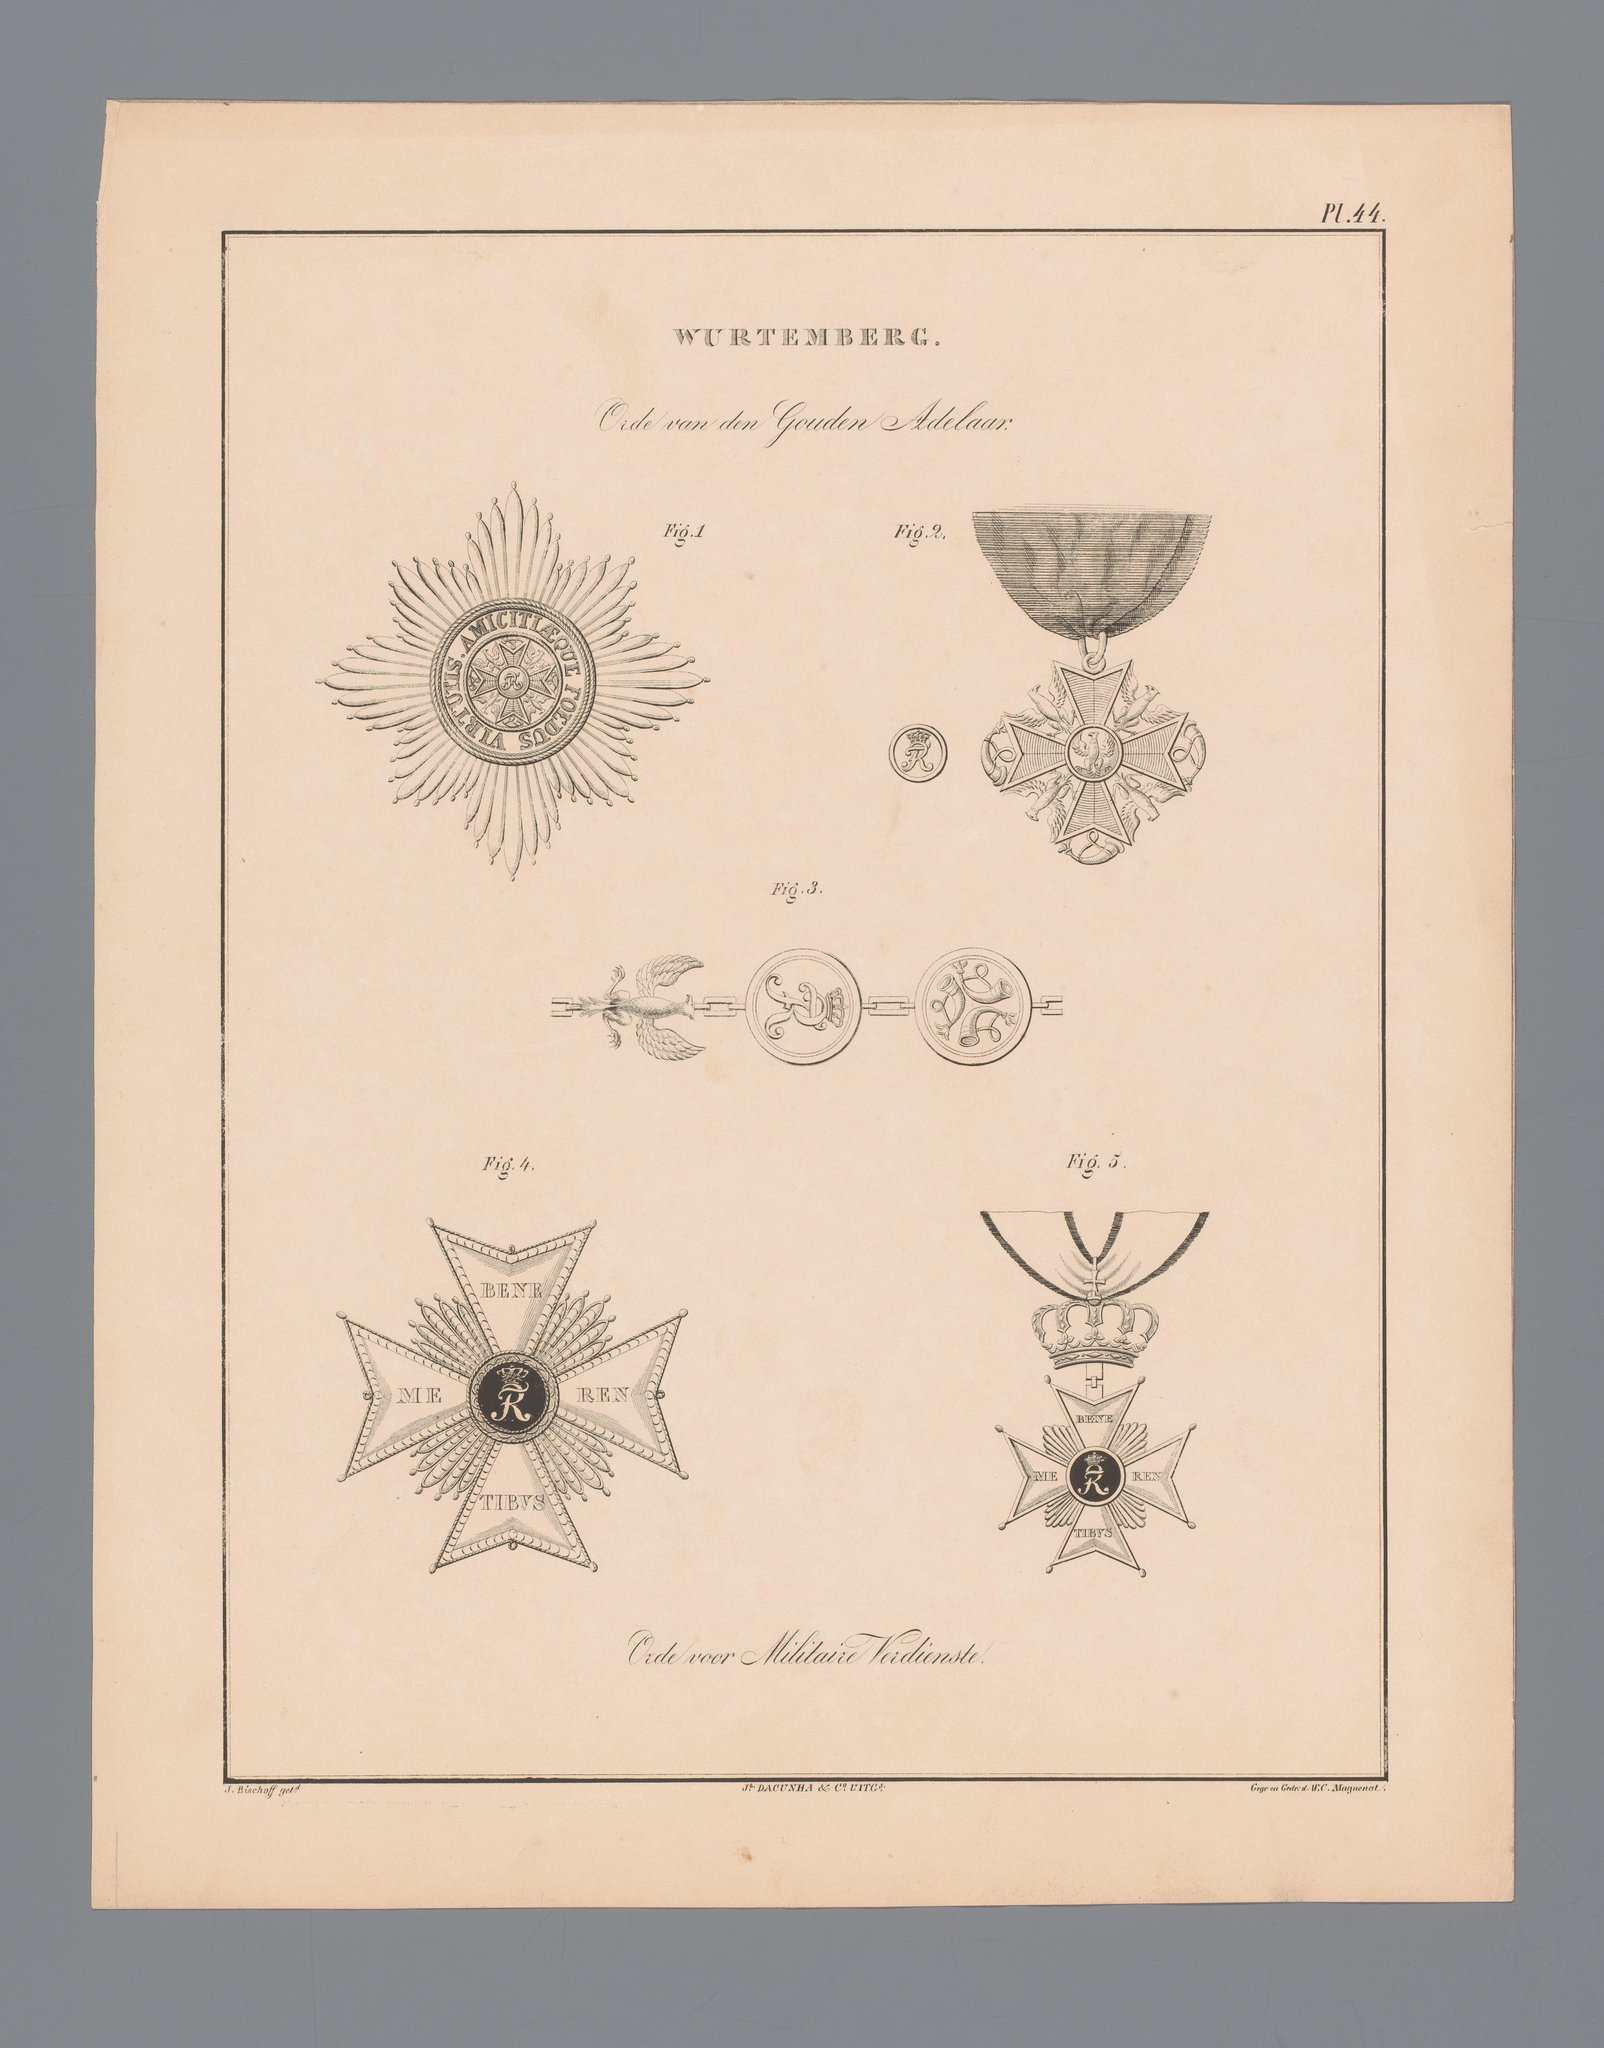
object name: print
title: Geschiedkundige beschrijving der oudere en nieuwere, thans bestaande ridderorden, zoo in als buiten Europa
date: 1843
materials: paper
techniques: lithograph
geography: amsterdam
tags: knighthood order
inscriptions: collector's mark: Lugt 2228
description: Deze prent werd uitgegeven in: G.L. de Rochemont en J. Bischoff, Geschiedkundige beschrijving der oudere en nieuwere, thans bestaande ridderorden, zoo in als buiten Europa (...) Amsterdam, Jb. da Cunha & Co: 1843.